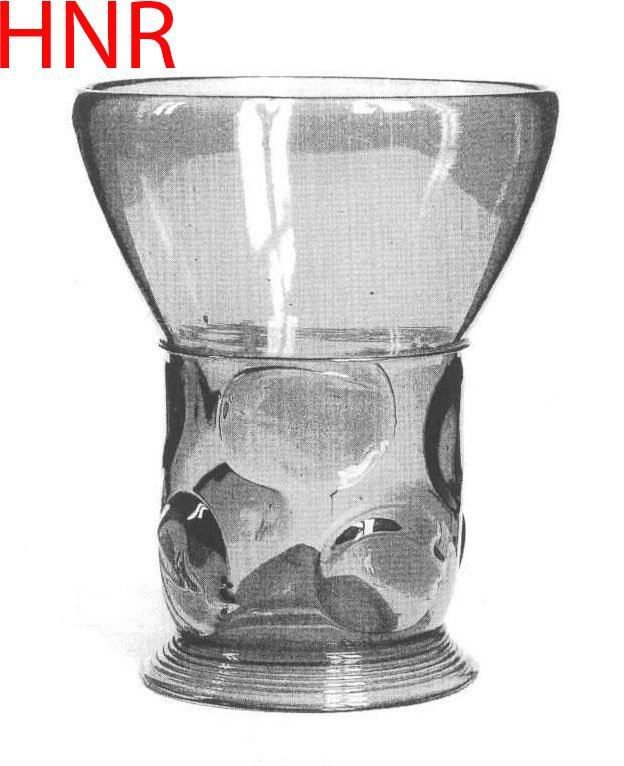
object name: berkenmeier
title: Berkemeyer with two rows of flat prunts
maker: Anonymous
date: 1625-1675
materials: glass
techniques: glassblowing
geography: germany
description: The Netherlands or Germany, c. 1625–1675 glass